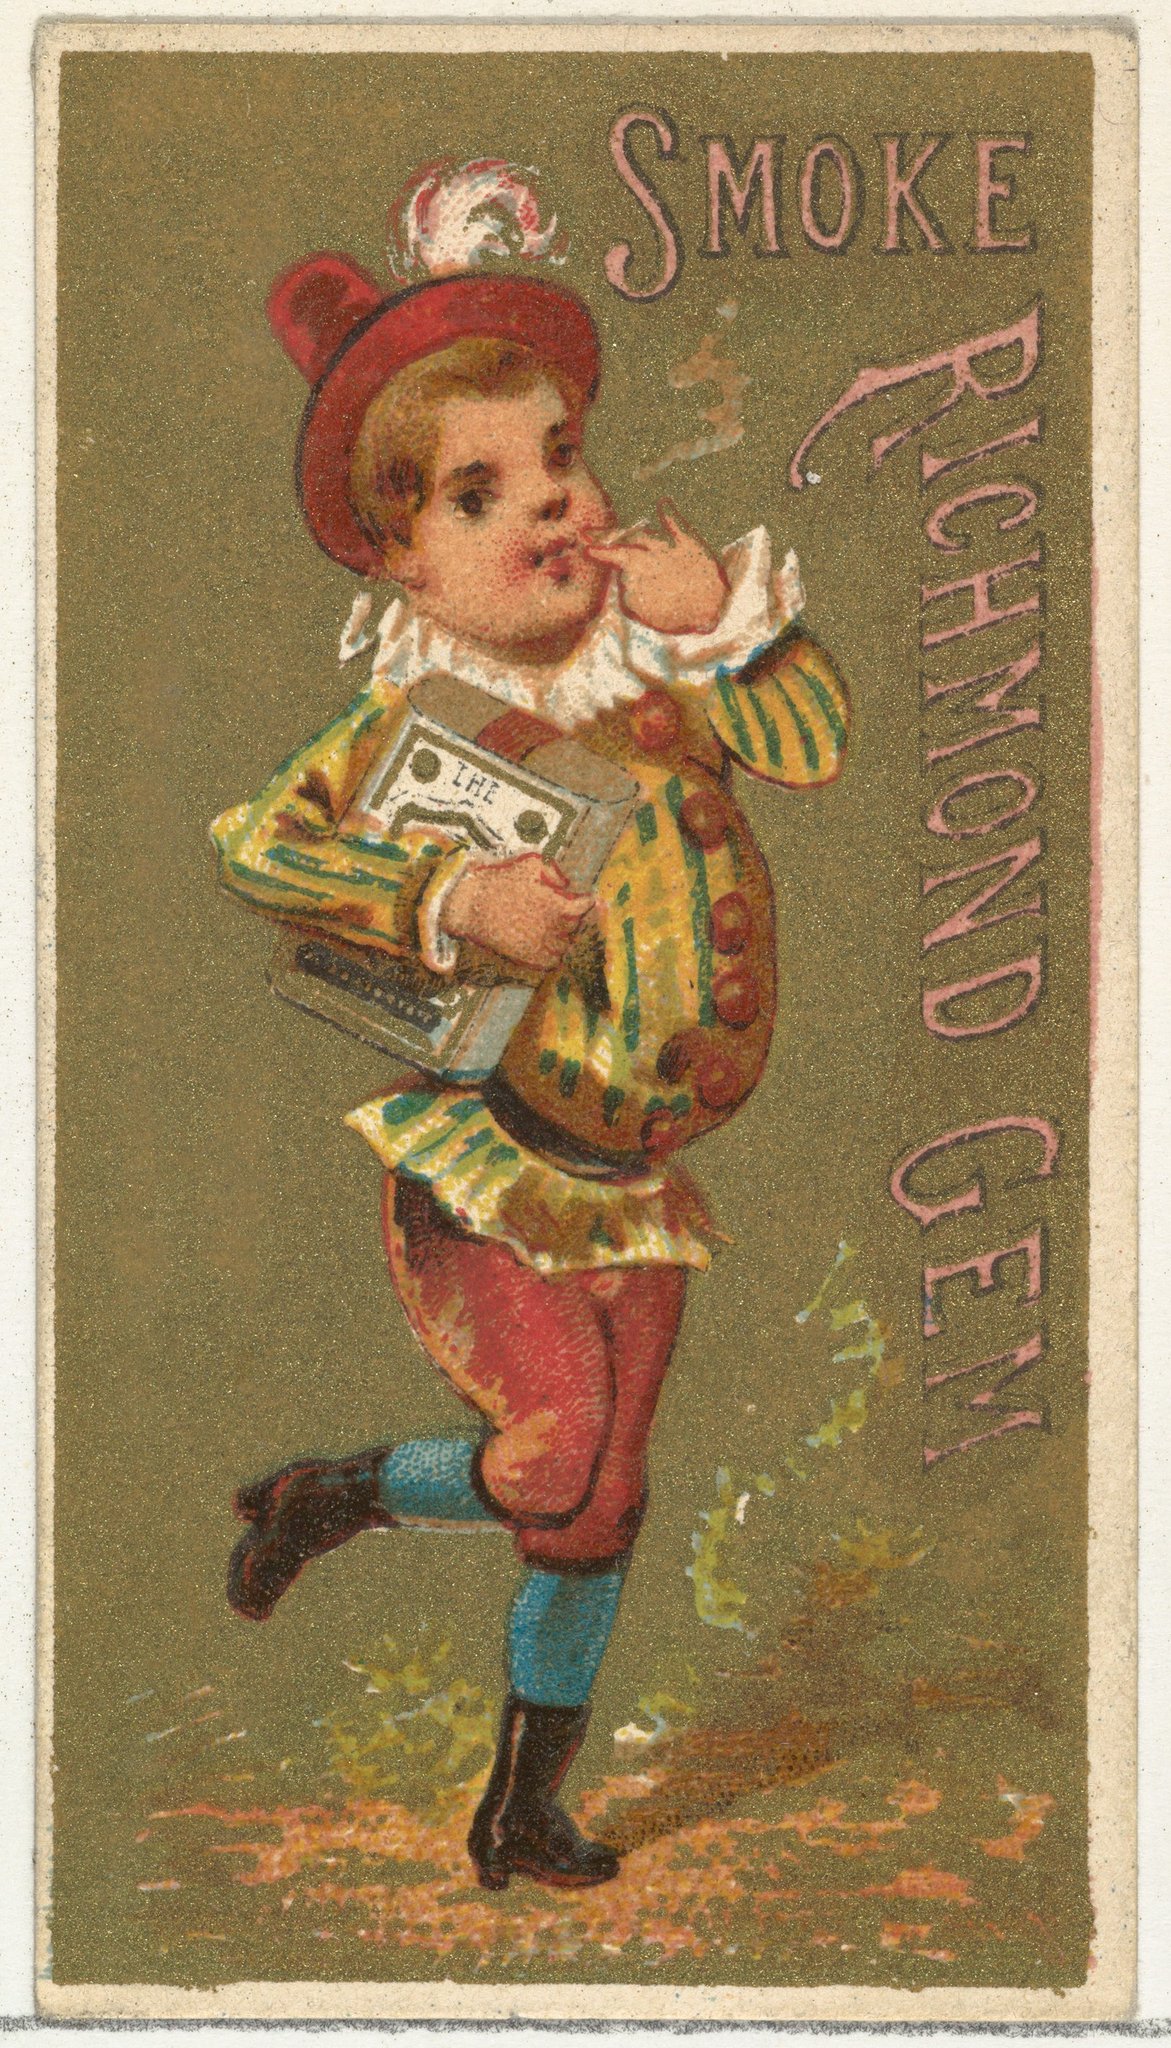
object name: print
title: From the Girls and Children series (N65) promoting Richmond Gem Cigarettes for Allen & Ginter brand tobacco products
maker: allen & ginter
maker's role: publisher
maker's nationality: american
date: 1886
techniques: color lithograph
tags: boys,smoking